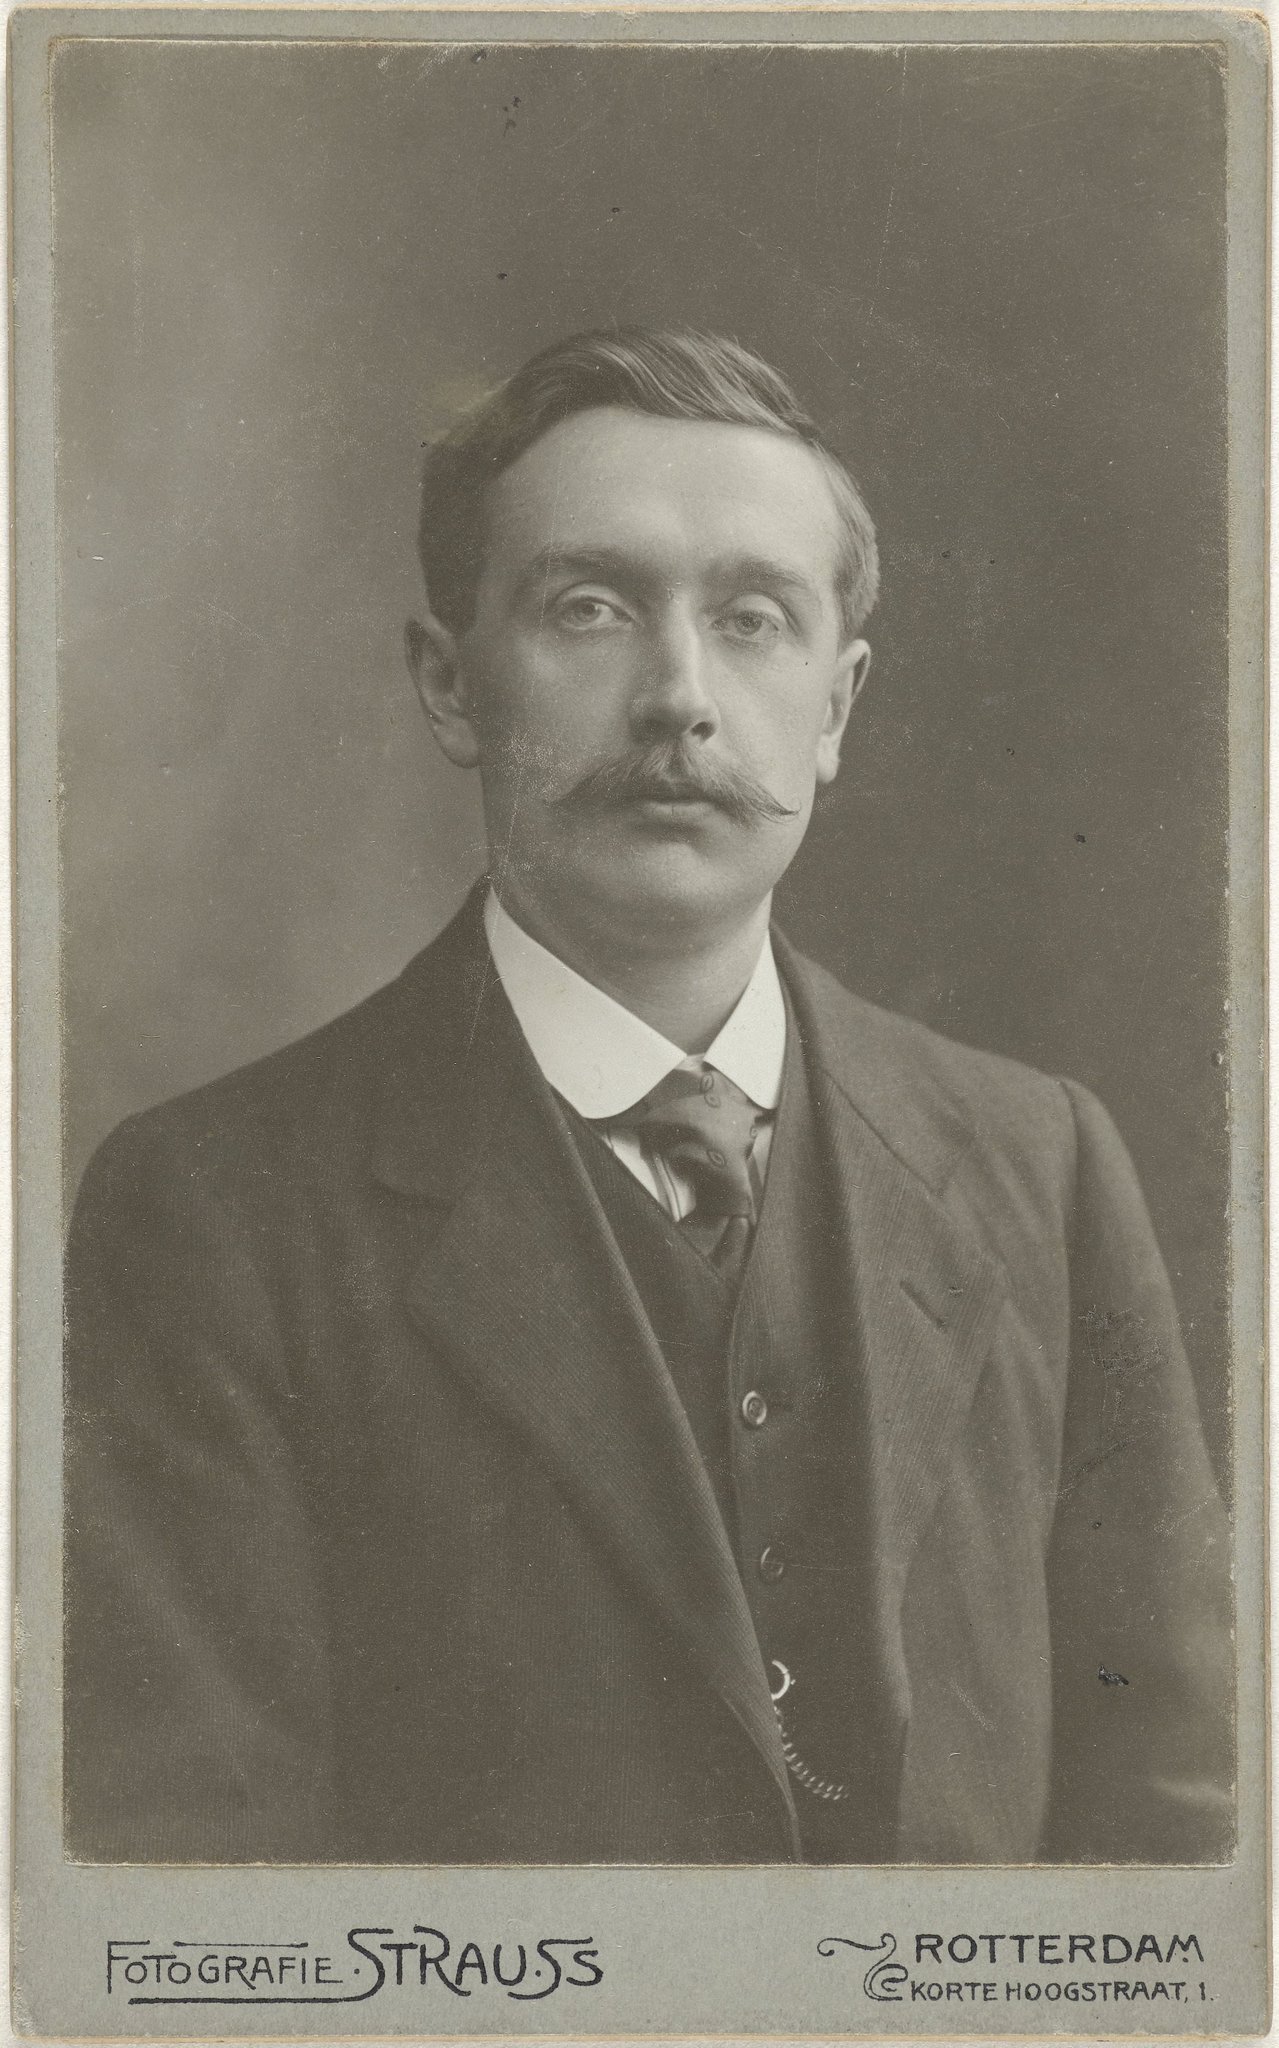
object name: carte de visite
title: Studioportret van man met snor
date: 1915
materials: cardboard, photographic support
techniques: matte daylight collodion silver print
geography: rotterdam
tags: rotterdam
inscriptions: name: ‘Fotografie Strauss Rptterdam in hte gebouw de Galerij Korte Hoogstraat 1’